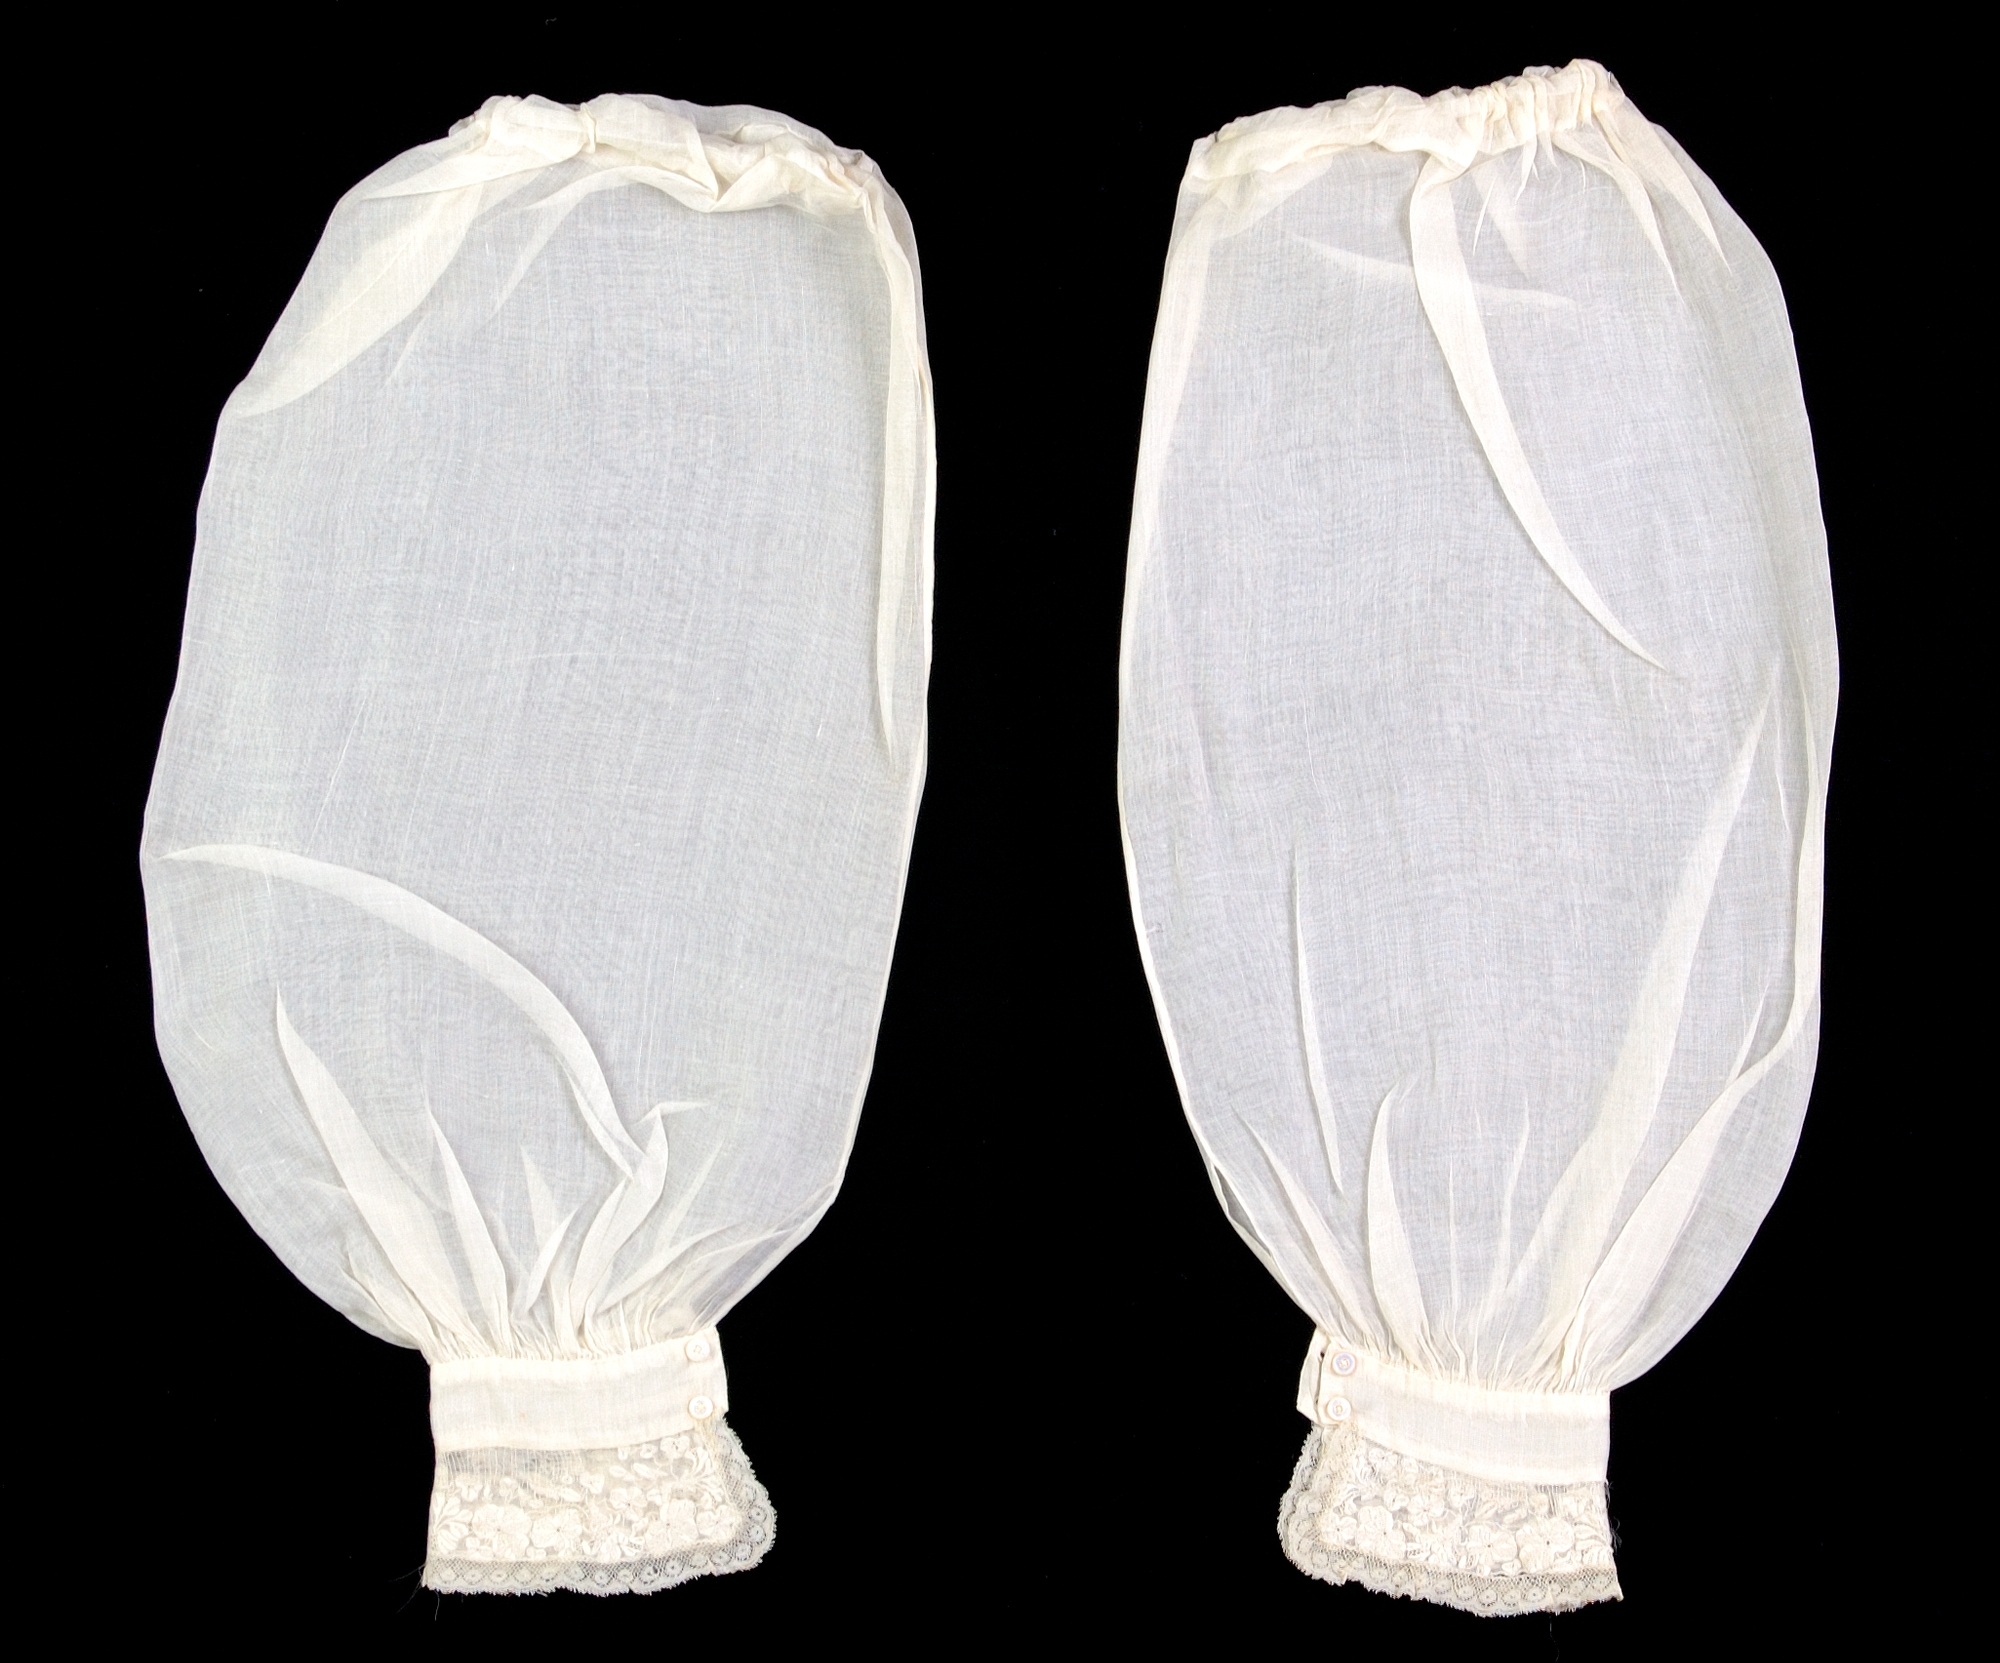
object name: undersleeves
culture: american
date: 1840-1850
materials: cotton